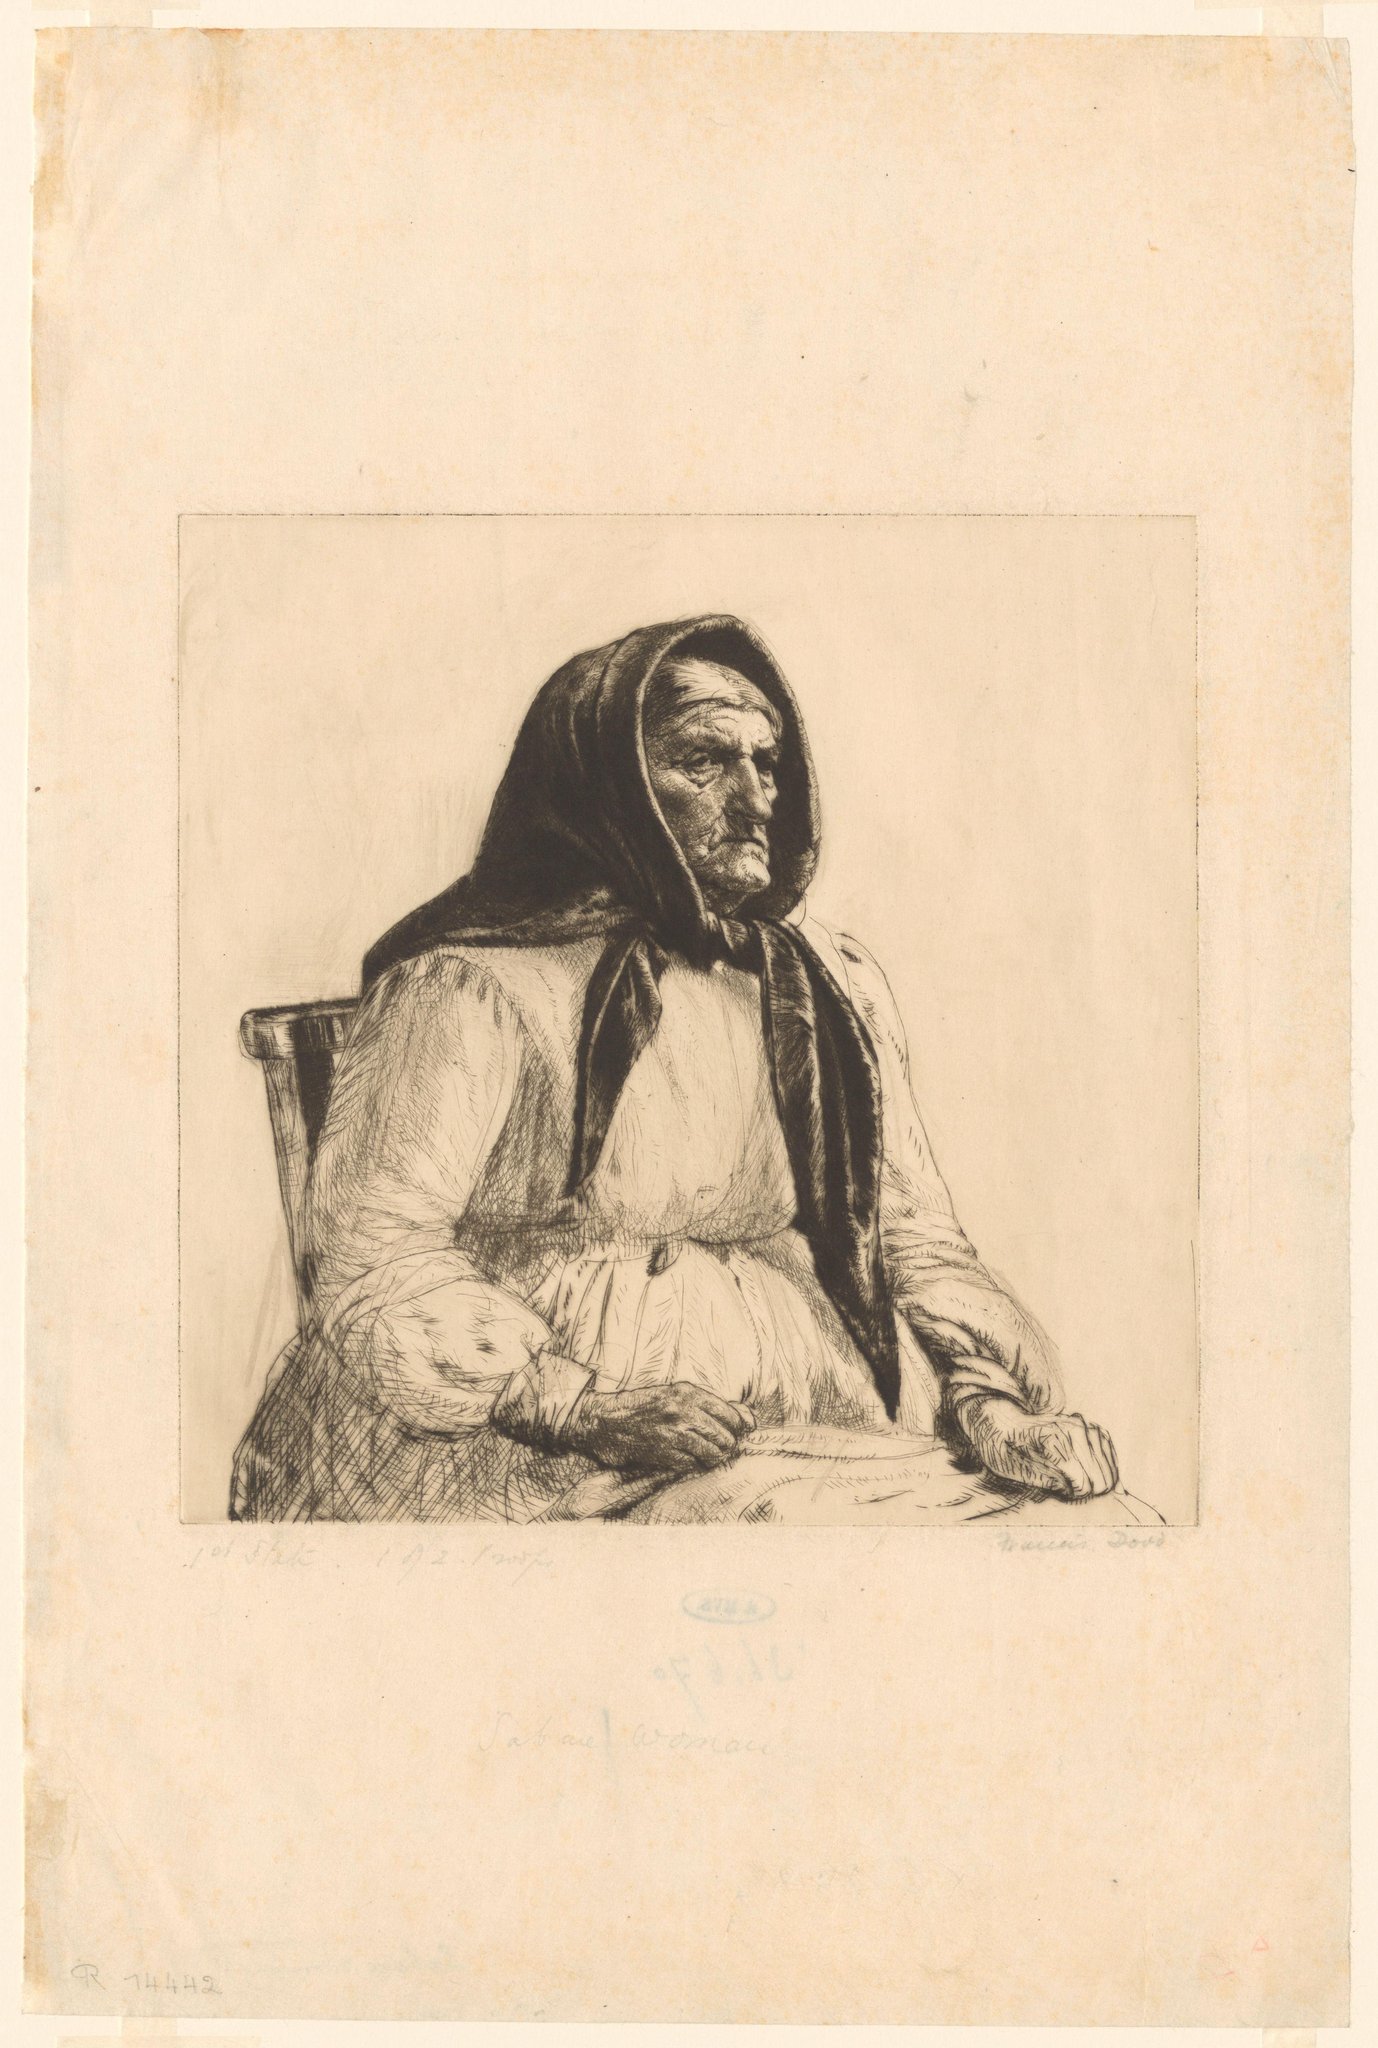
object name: print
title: Portret van een onbekende oude vrouw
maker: francis dodd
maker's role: print maker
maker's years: 1874-1949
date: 1884-1936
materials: paper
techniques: drypoint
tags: historical persons, old woman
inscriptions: collector's mark: Lugt 2228, annotation: ‘Sabare woman’